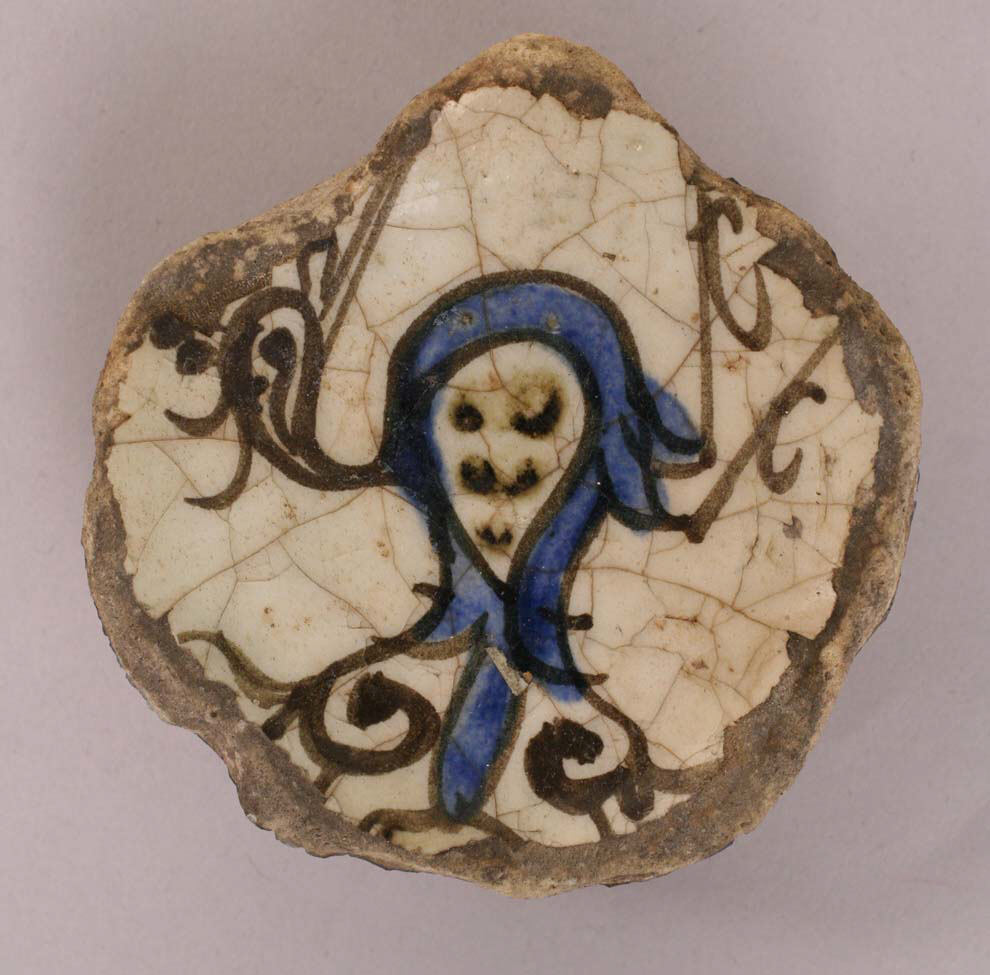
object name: fragment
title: Fragment of a Bowl or Cup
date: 1201-1600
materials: glaze, stonepaste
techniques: painting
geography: egypt